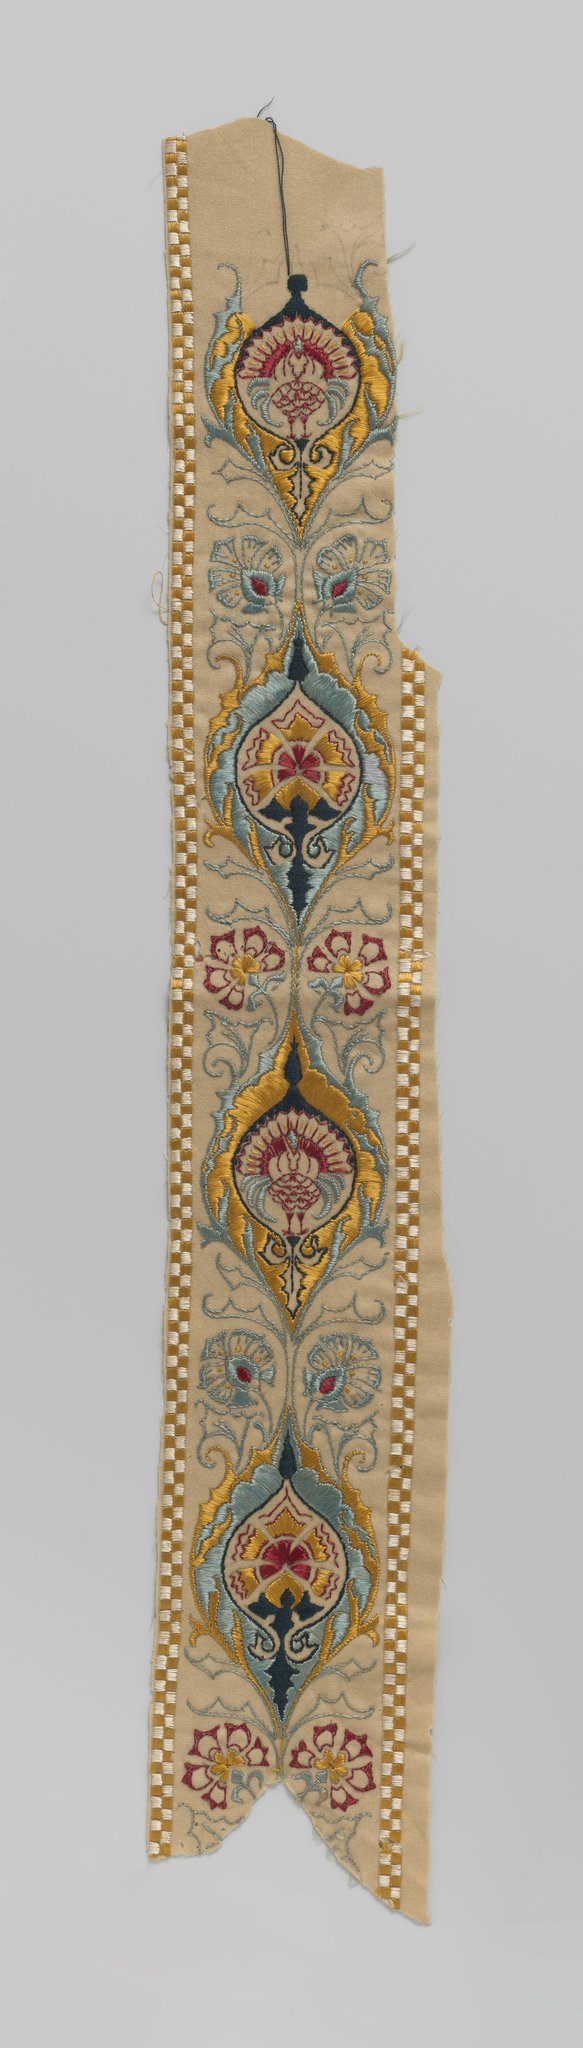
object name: embroidery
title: Onvoltooid fragment borduurwerk met een repeterend motief van veelkleurige zijde op naturelkleurige wollen kamgaren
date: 1900-1910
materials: ink, silk, textile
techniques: drawing, embroidered, weave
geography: amsterdam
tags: designer, h.j. winkelman, m.g. winkelman-sanders, amsterdam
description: Onvoltooid fragment borduurwerk, mogelijk een proeflap, met een repeterend motief van veelkleurige zijde op naturelkleurige wollen kamgaren. Het borduurwerk op het langwerpige fragment is langs de lange zijden afgeknipt en gedeeltelijk weggeknipt. Uit het onderste, korte eind is een punt geknipt terwijl aan de bovenkant, die onvoltooid is gebleven, een stuk gedeeltelijk onbewerkte, wollen stof van ca. 4 cm over is. Hier is een deel van de ondertekening met inkt(?) zichtbaar. Ornament: tussen twee geblokte randen bevindt zich een repeterend motief van puntige medaillons alternerend gevuld met symmetrische blad- en bloemmotieven of een pauw met opstaande veren(?), afgewisseld met bloemmotieven ter weerszijden van de punten. Het borduurwerk is uitgevoerd in de kleuren goudgeel, zilverwit, ijsblauw, wijnrood en marineblauw.